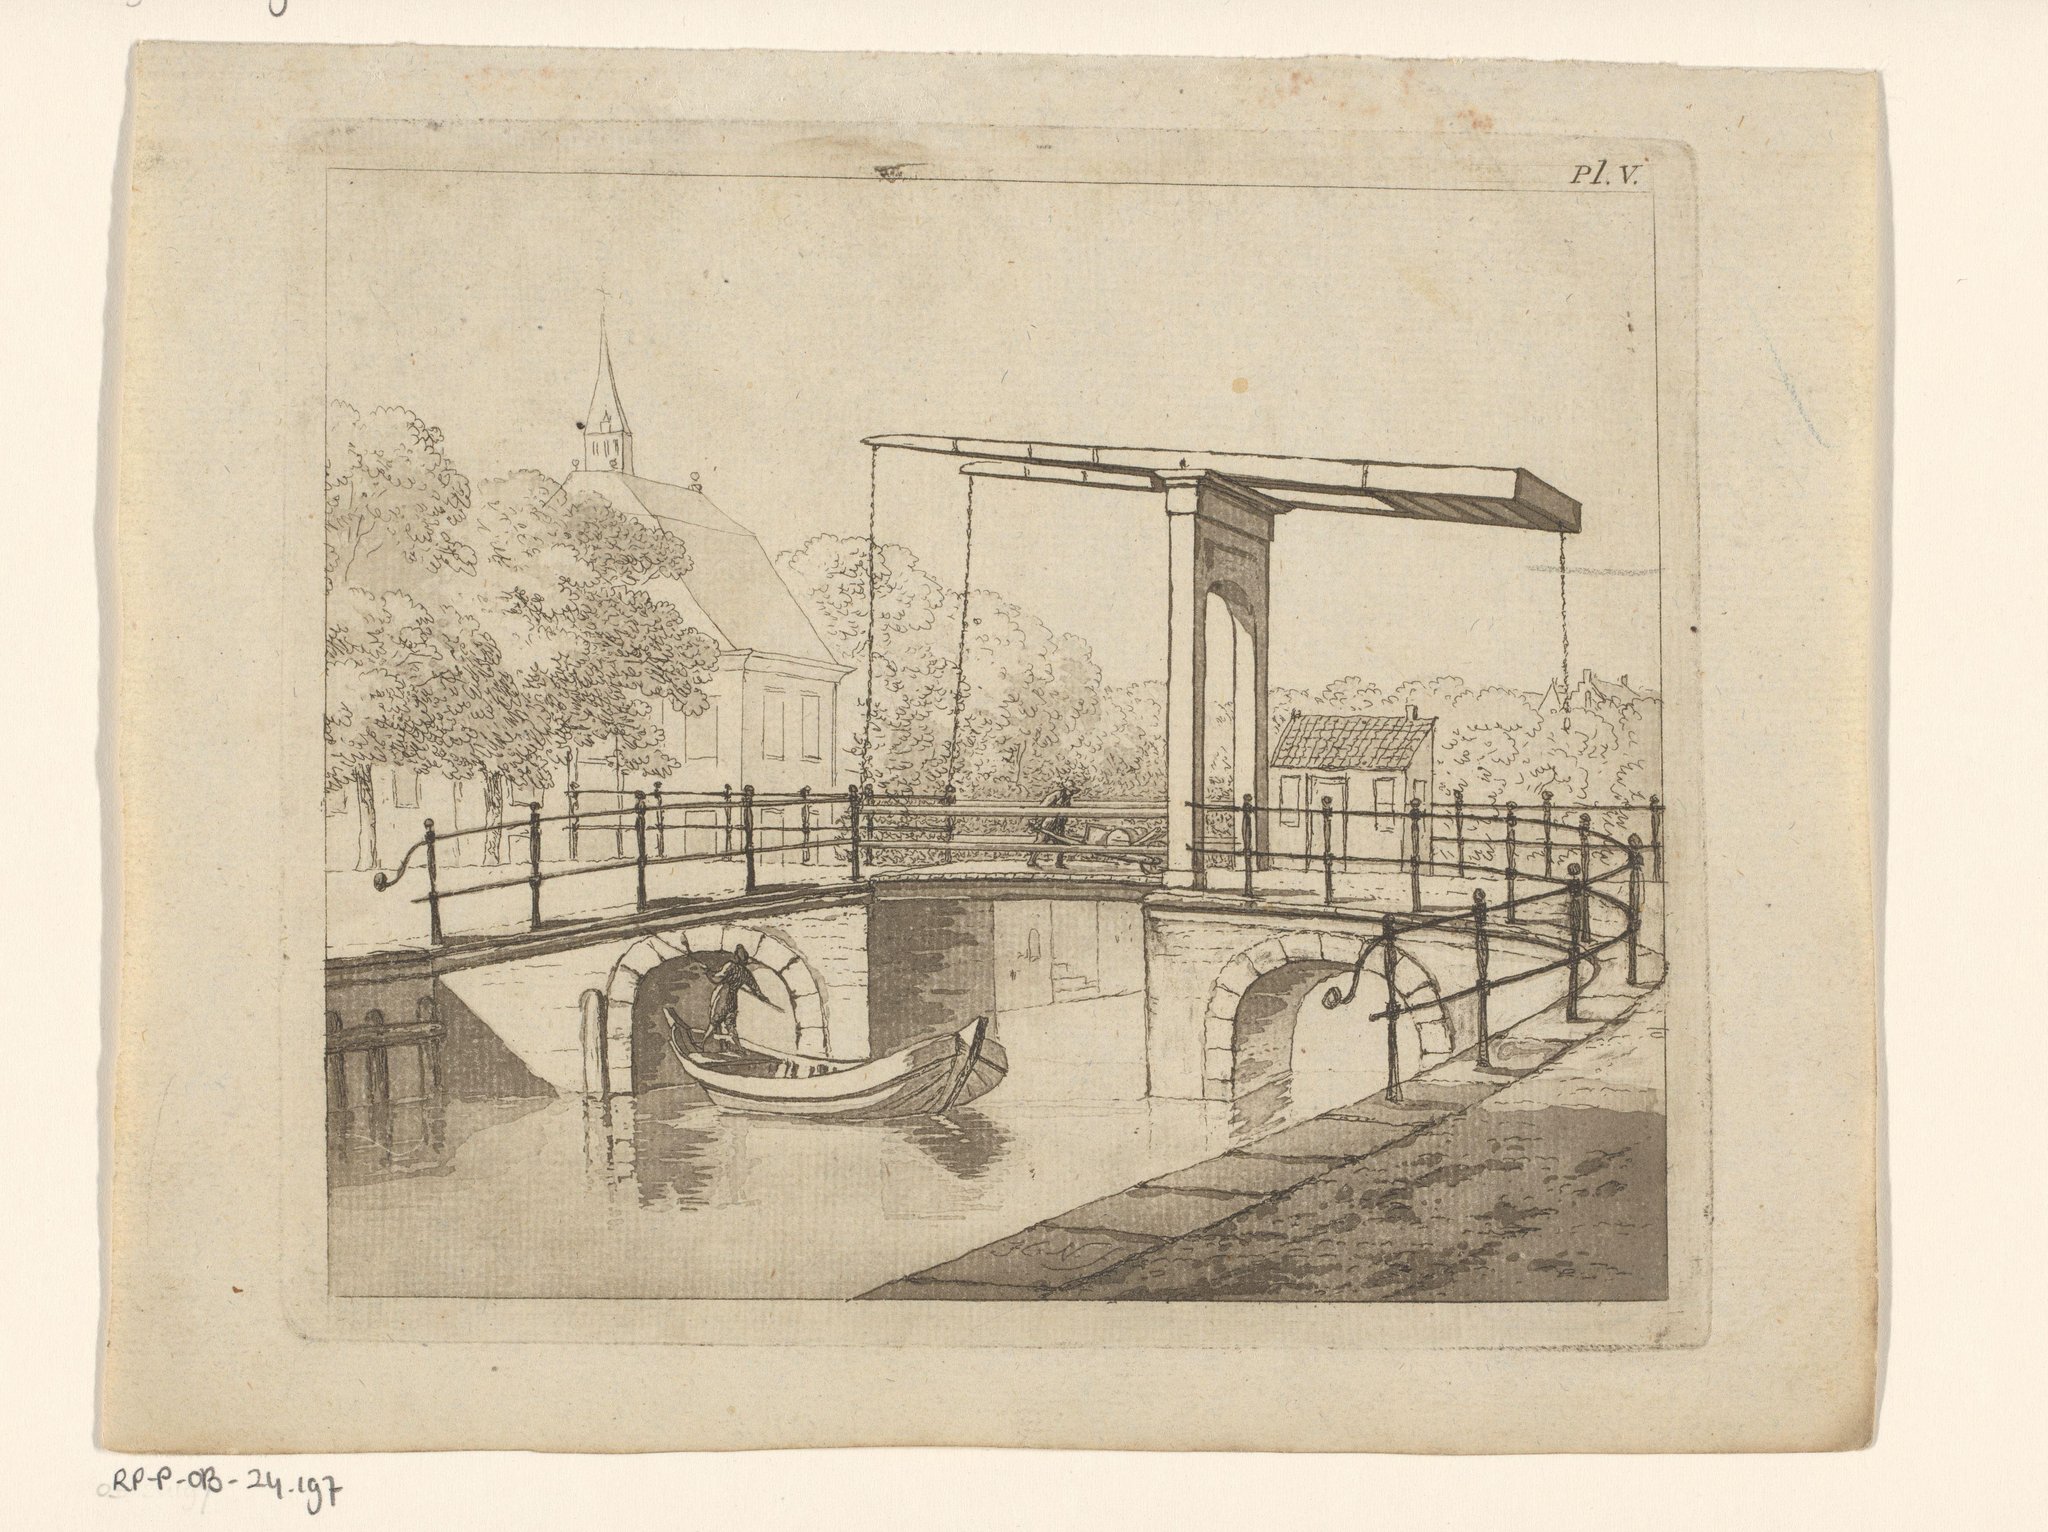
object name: print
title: Ophaalbrug over een gracht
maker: hermanus numan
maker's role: draughtsman, painter, print maker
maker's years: 1744-1820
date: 1754-1825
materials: paper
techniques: aquatint, etching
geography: netherlands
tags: drawbridge ~ fortified city (+ variant), rowing-boat, canoe, etc., wheelbarrow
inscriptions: collector's mark: Lugt 2228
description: Een ophaalbrug over een gracht waarover een man met een kruiwagen loopt. In de gracht drijft een sloep, waarin een man staat. Links aan de overzijde een kerk met daarachter een kerktoren. Rechtsboven: Pl. V.